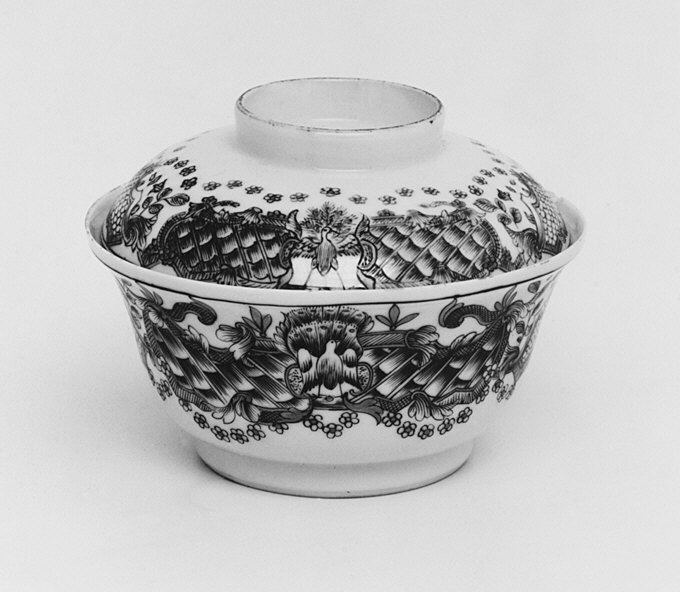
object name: bowl with cover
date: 1760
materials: hard paste porcelain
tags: peacocks